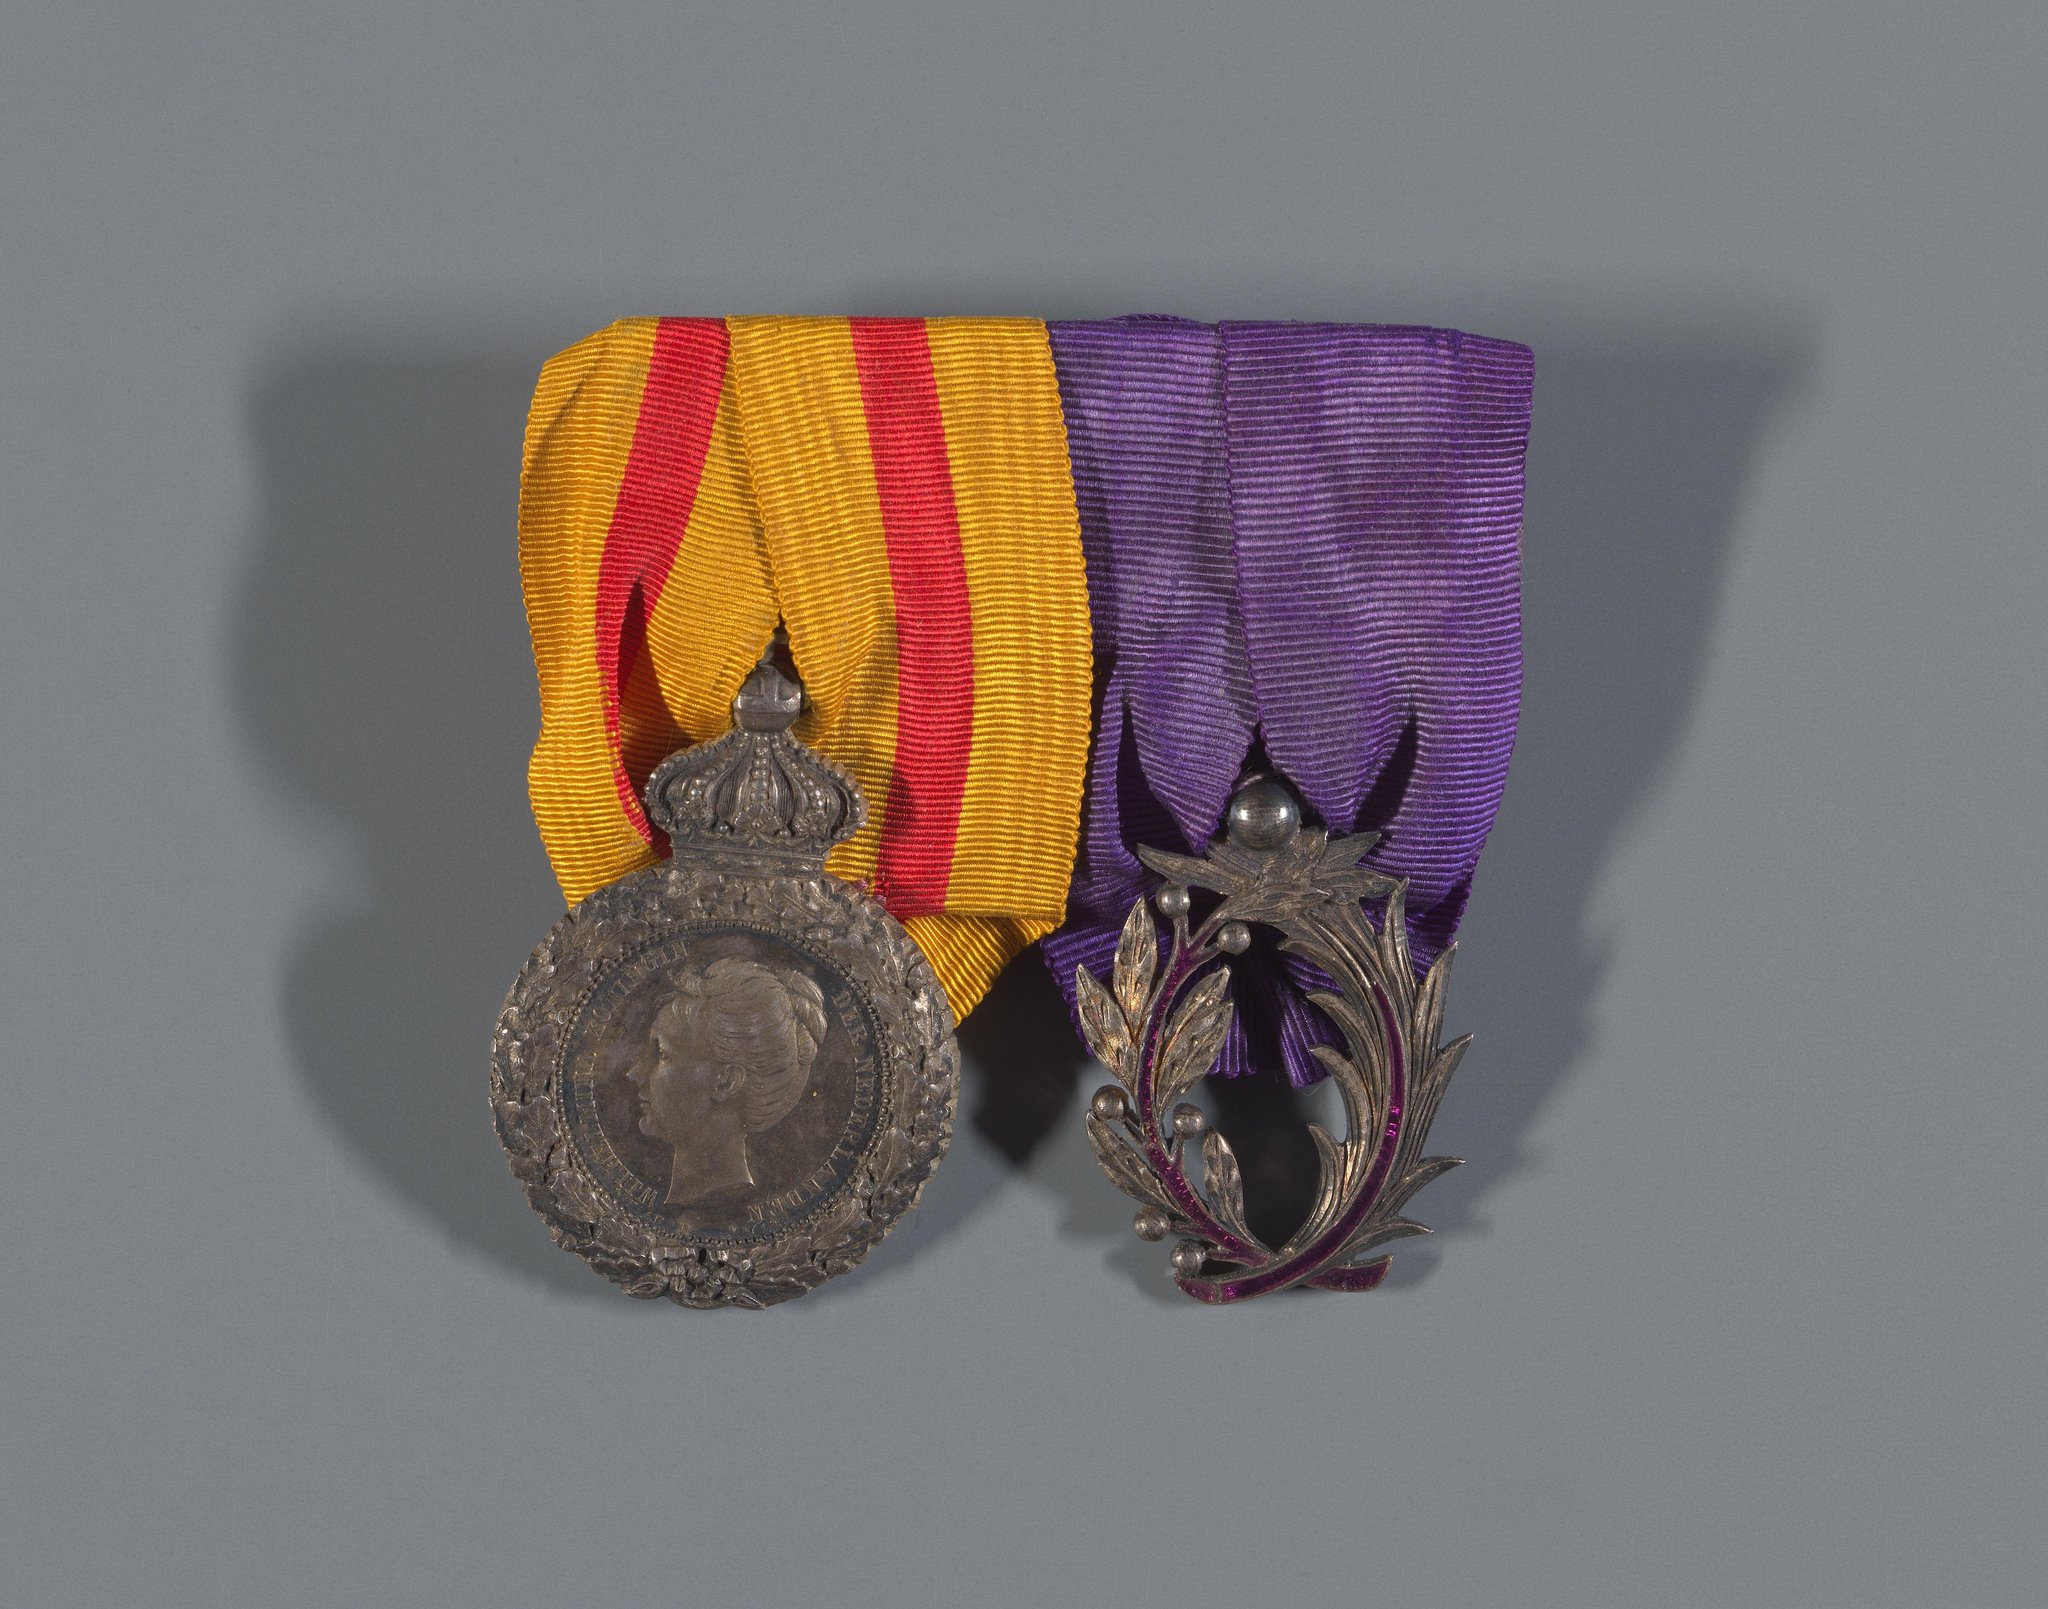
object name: medal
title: Erepenning voor Verdiensten jegens Openbare Verzamelingen (type 3) toegekend aan Thédore van Lelyveld in 1900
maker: Anonymous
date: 1900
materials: silk, silver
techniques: striking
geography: netherlands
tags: the hague, painter, théodore van lelyveld, suriname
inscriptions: inscription: ‘Voor verdienste jegens s’rijks musea aan Th.B. van Lelyveld 1900’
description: Erepenning voor Verdiensten jegens Openbare Verzamelingen (type 3), de zgn. 'Museummedaille' of 'Museumpenning', toegekend aan Thédore van Lelyveld in 1900. Draagpenning met portret van koningin Wilhelmina en een lauwerkrans. De twee objecten aan een speld, beide met zijden linten.